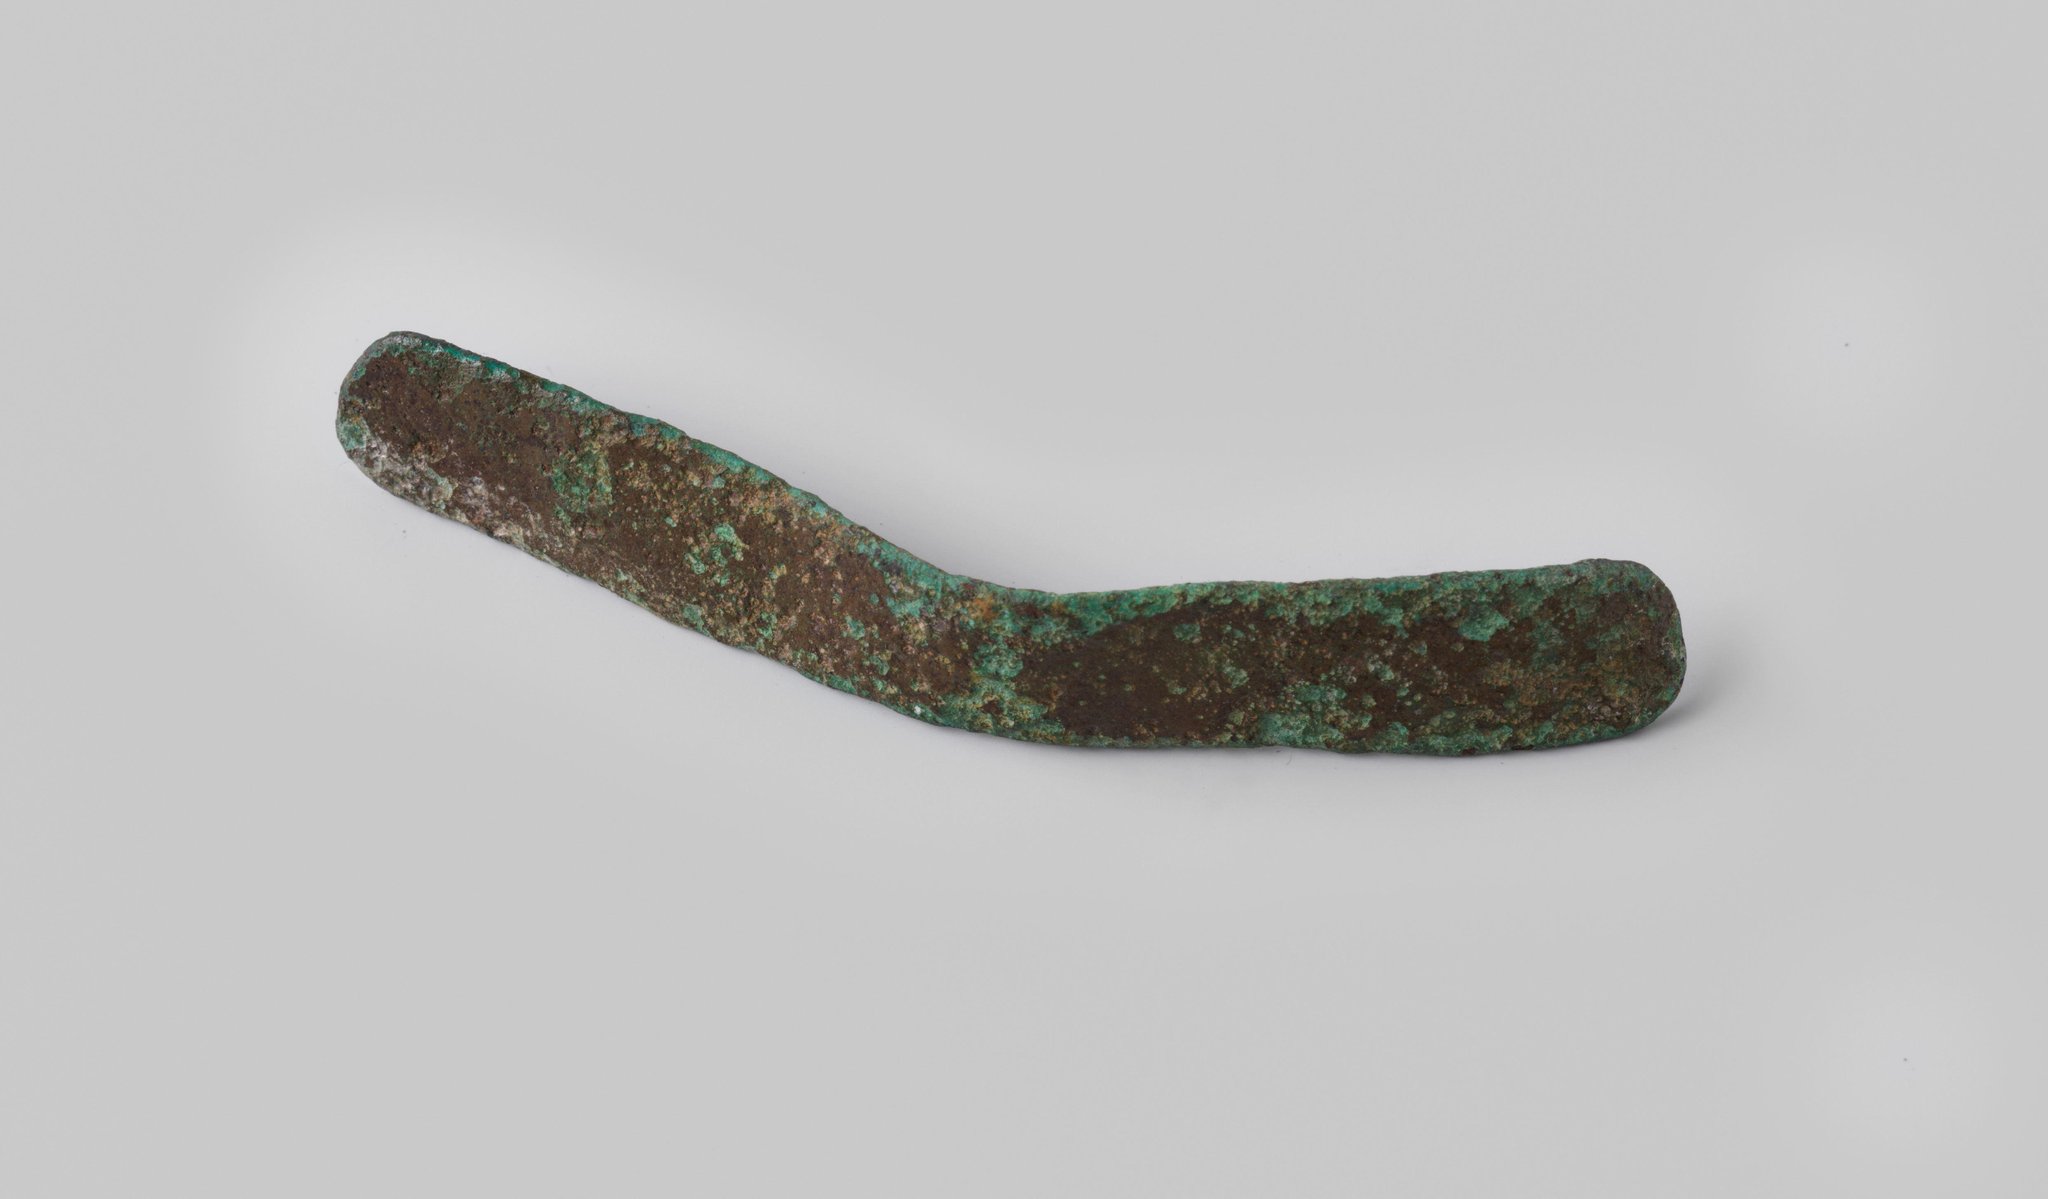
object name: fragment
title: Fragment van koper uit het wrak van de Oost-Indiëvaarder Hollandia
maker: Anonymous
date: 1700-1743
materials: copper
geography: netherlands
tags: verenigde oostindische compagnie, hollandia (schip), annet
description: Varied parts or fragments, strips and strip-shaped fragments; fragm.